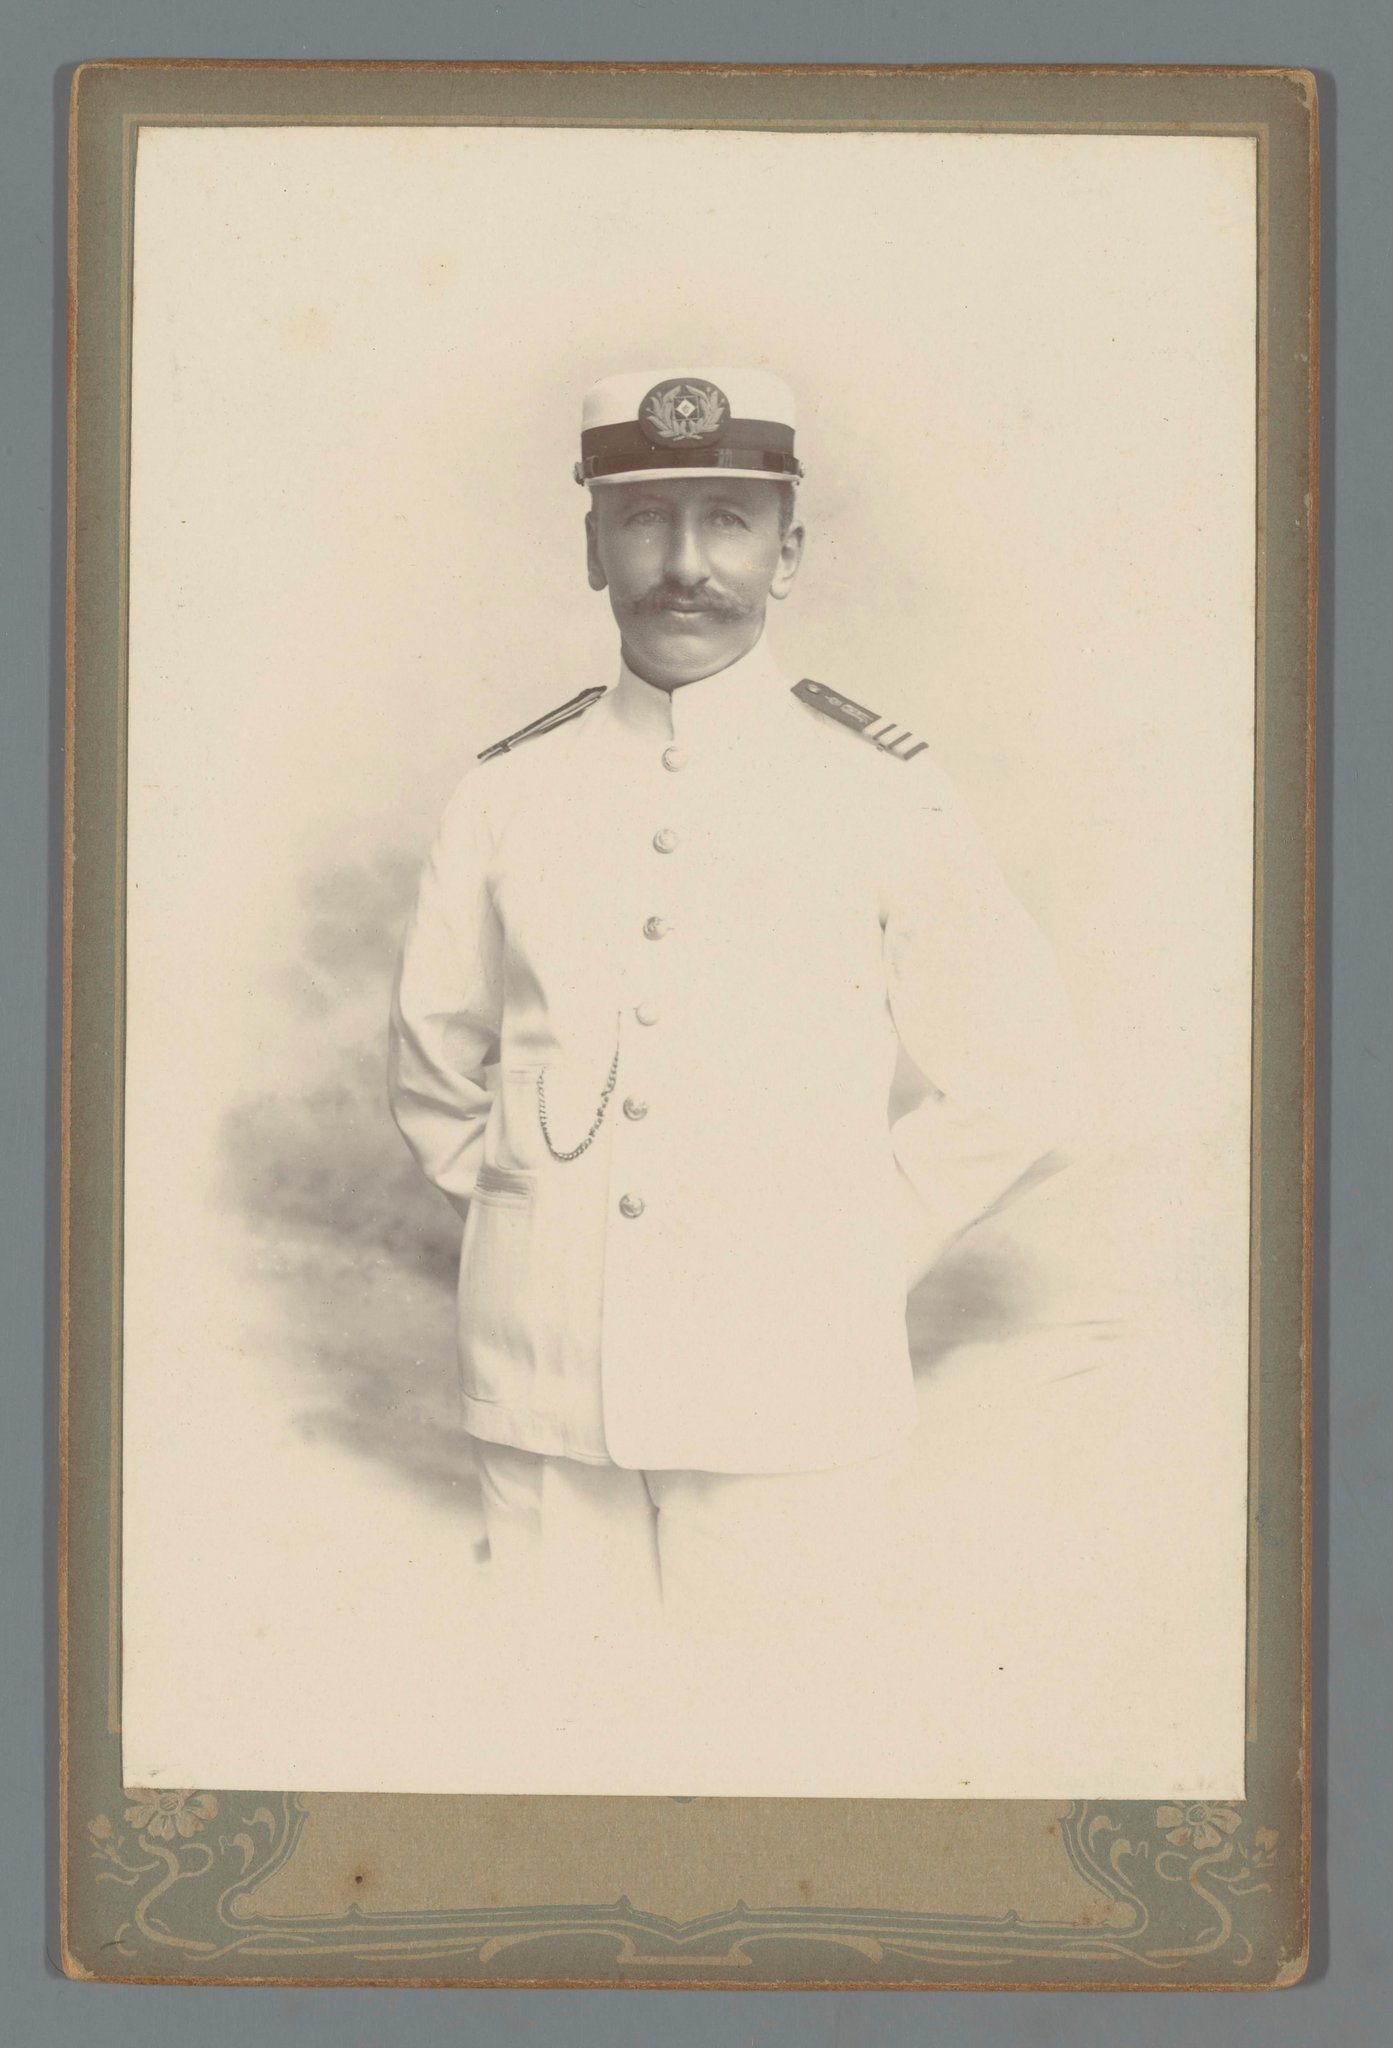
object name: photograph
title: Portret van een man in marine-uniform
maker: Anonymous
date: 1890-1920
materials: cardboard, photographic support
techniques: matte daylight collodion silver print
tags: ranks in the navy